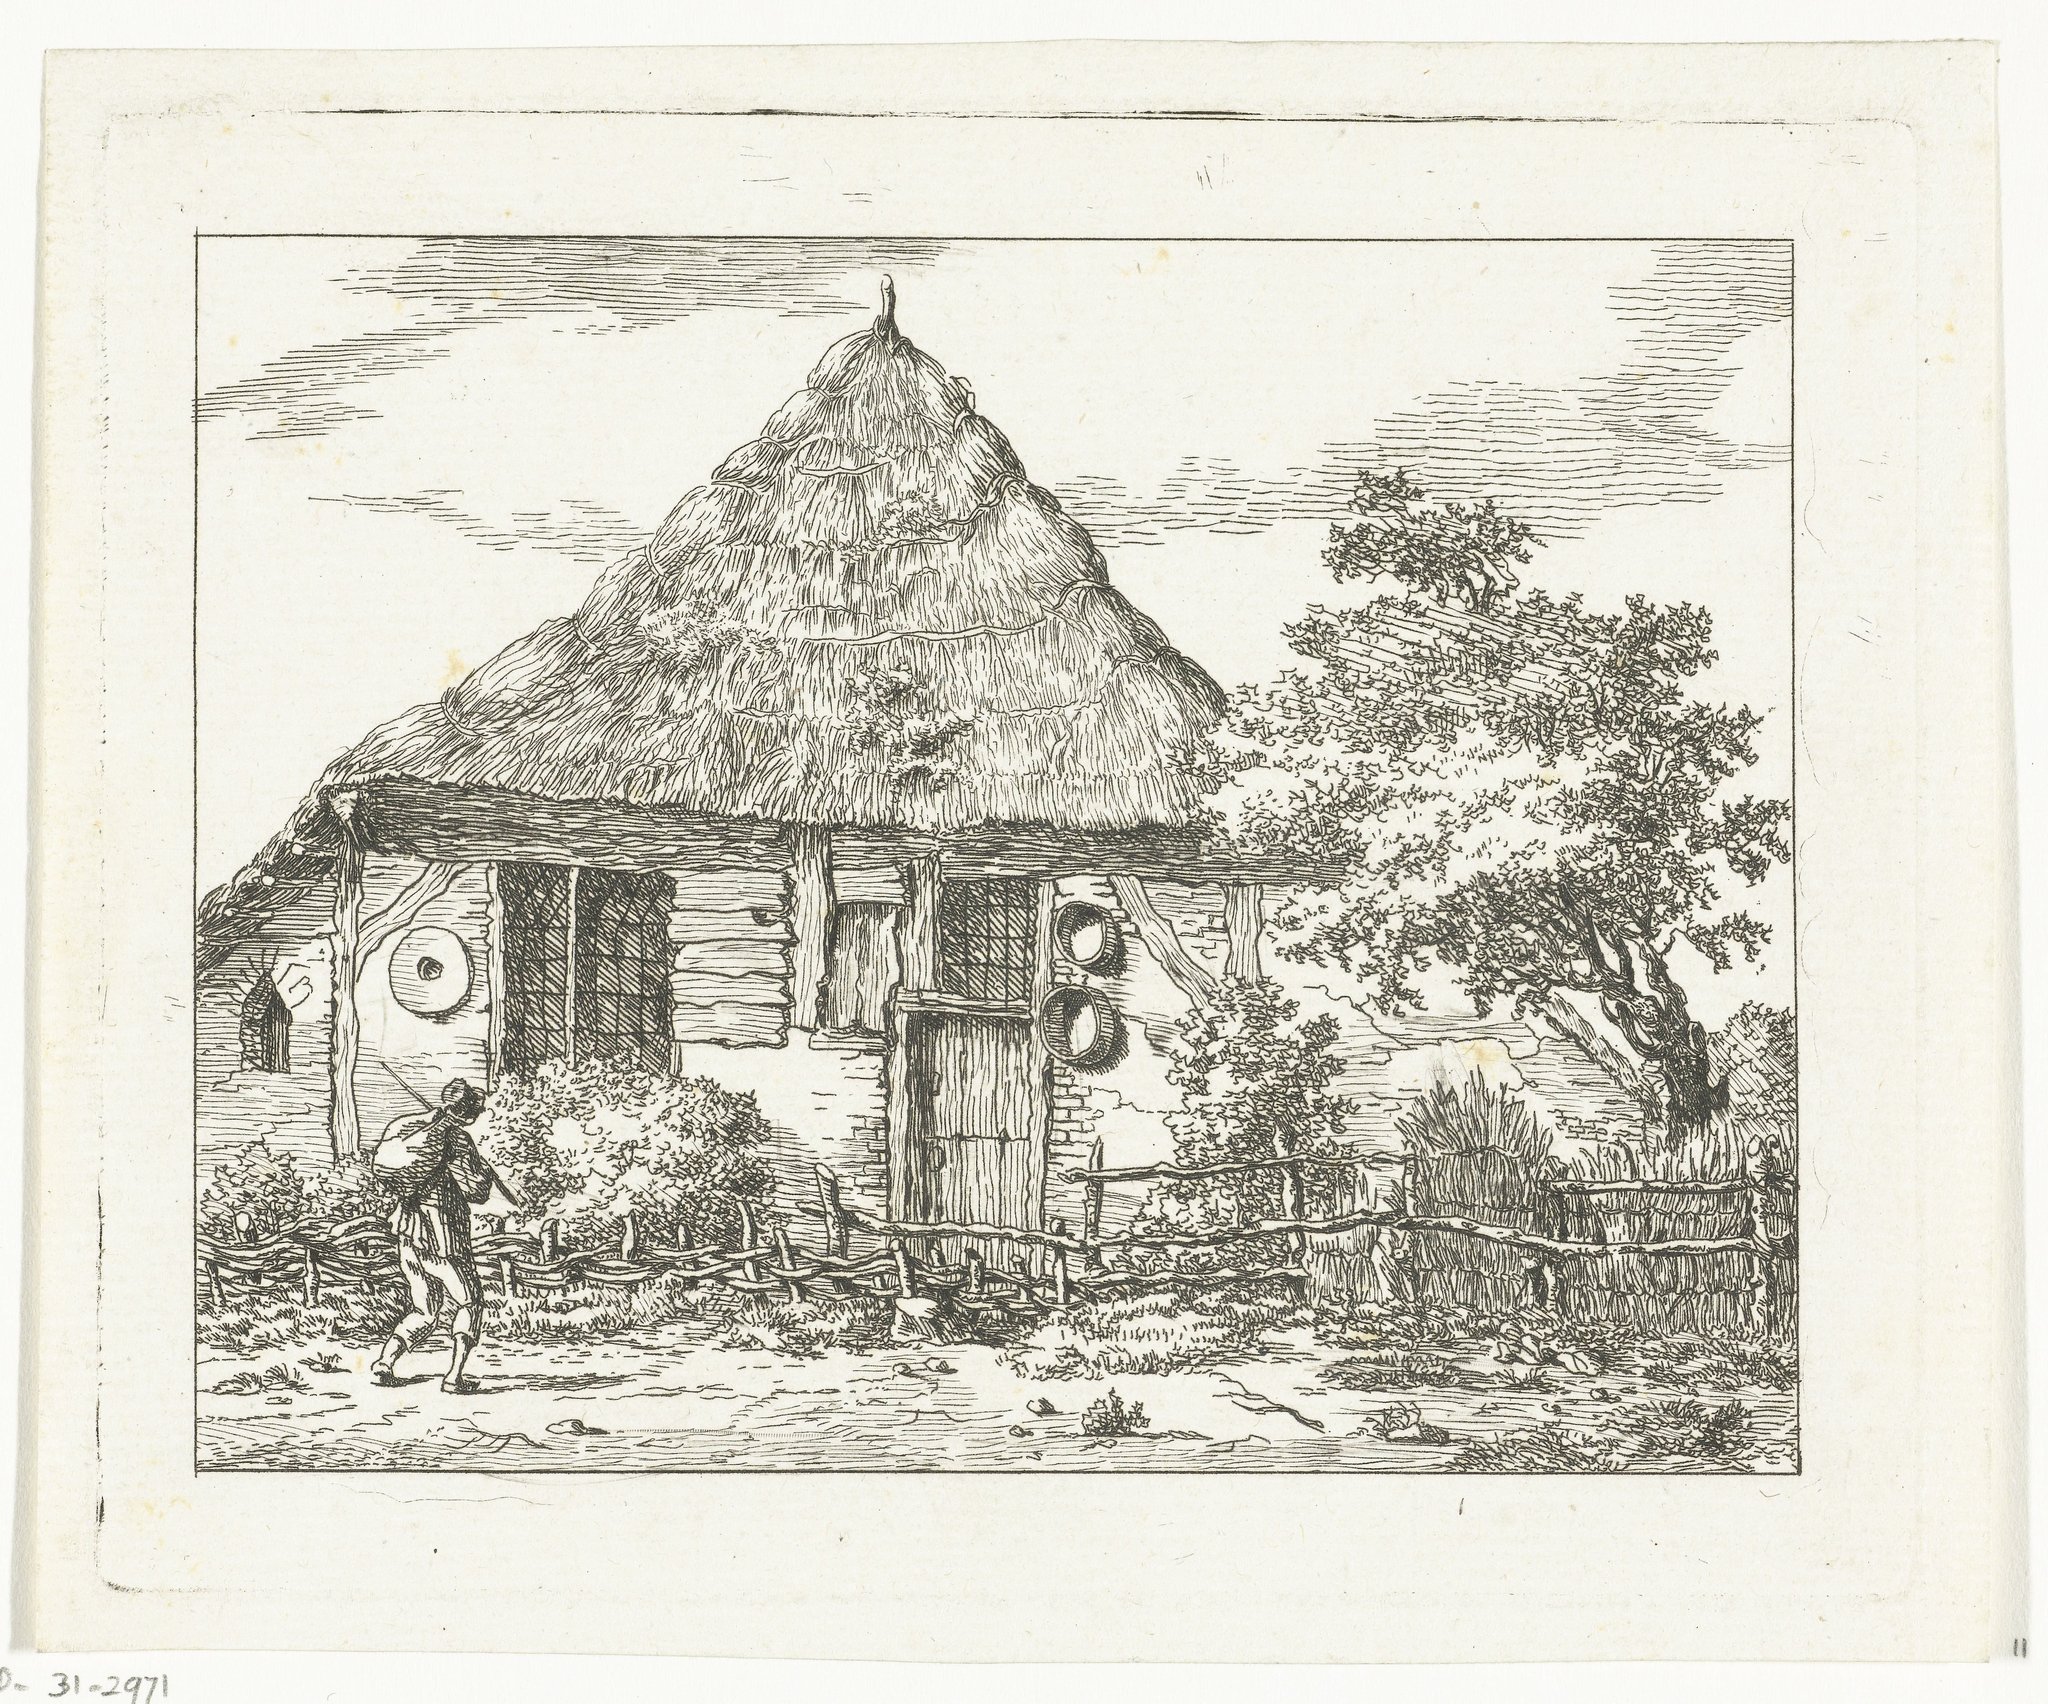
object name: print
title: Man met rugzak voor een huis te Staphorst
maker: anthonie van den bos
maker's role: draughtsman, print maker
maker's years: 1763-1838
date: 1778-1838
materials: paper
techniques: etching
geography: netherlands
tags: farm (building)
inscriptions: collector's mark: Lugt 2228